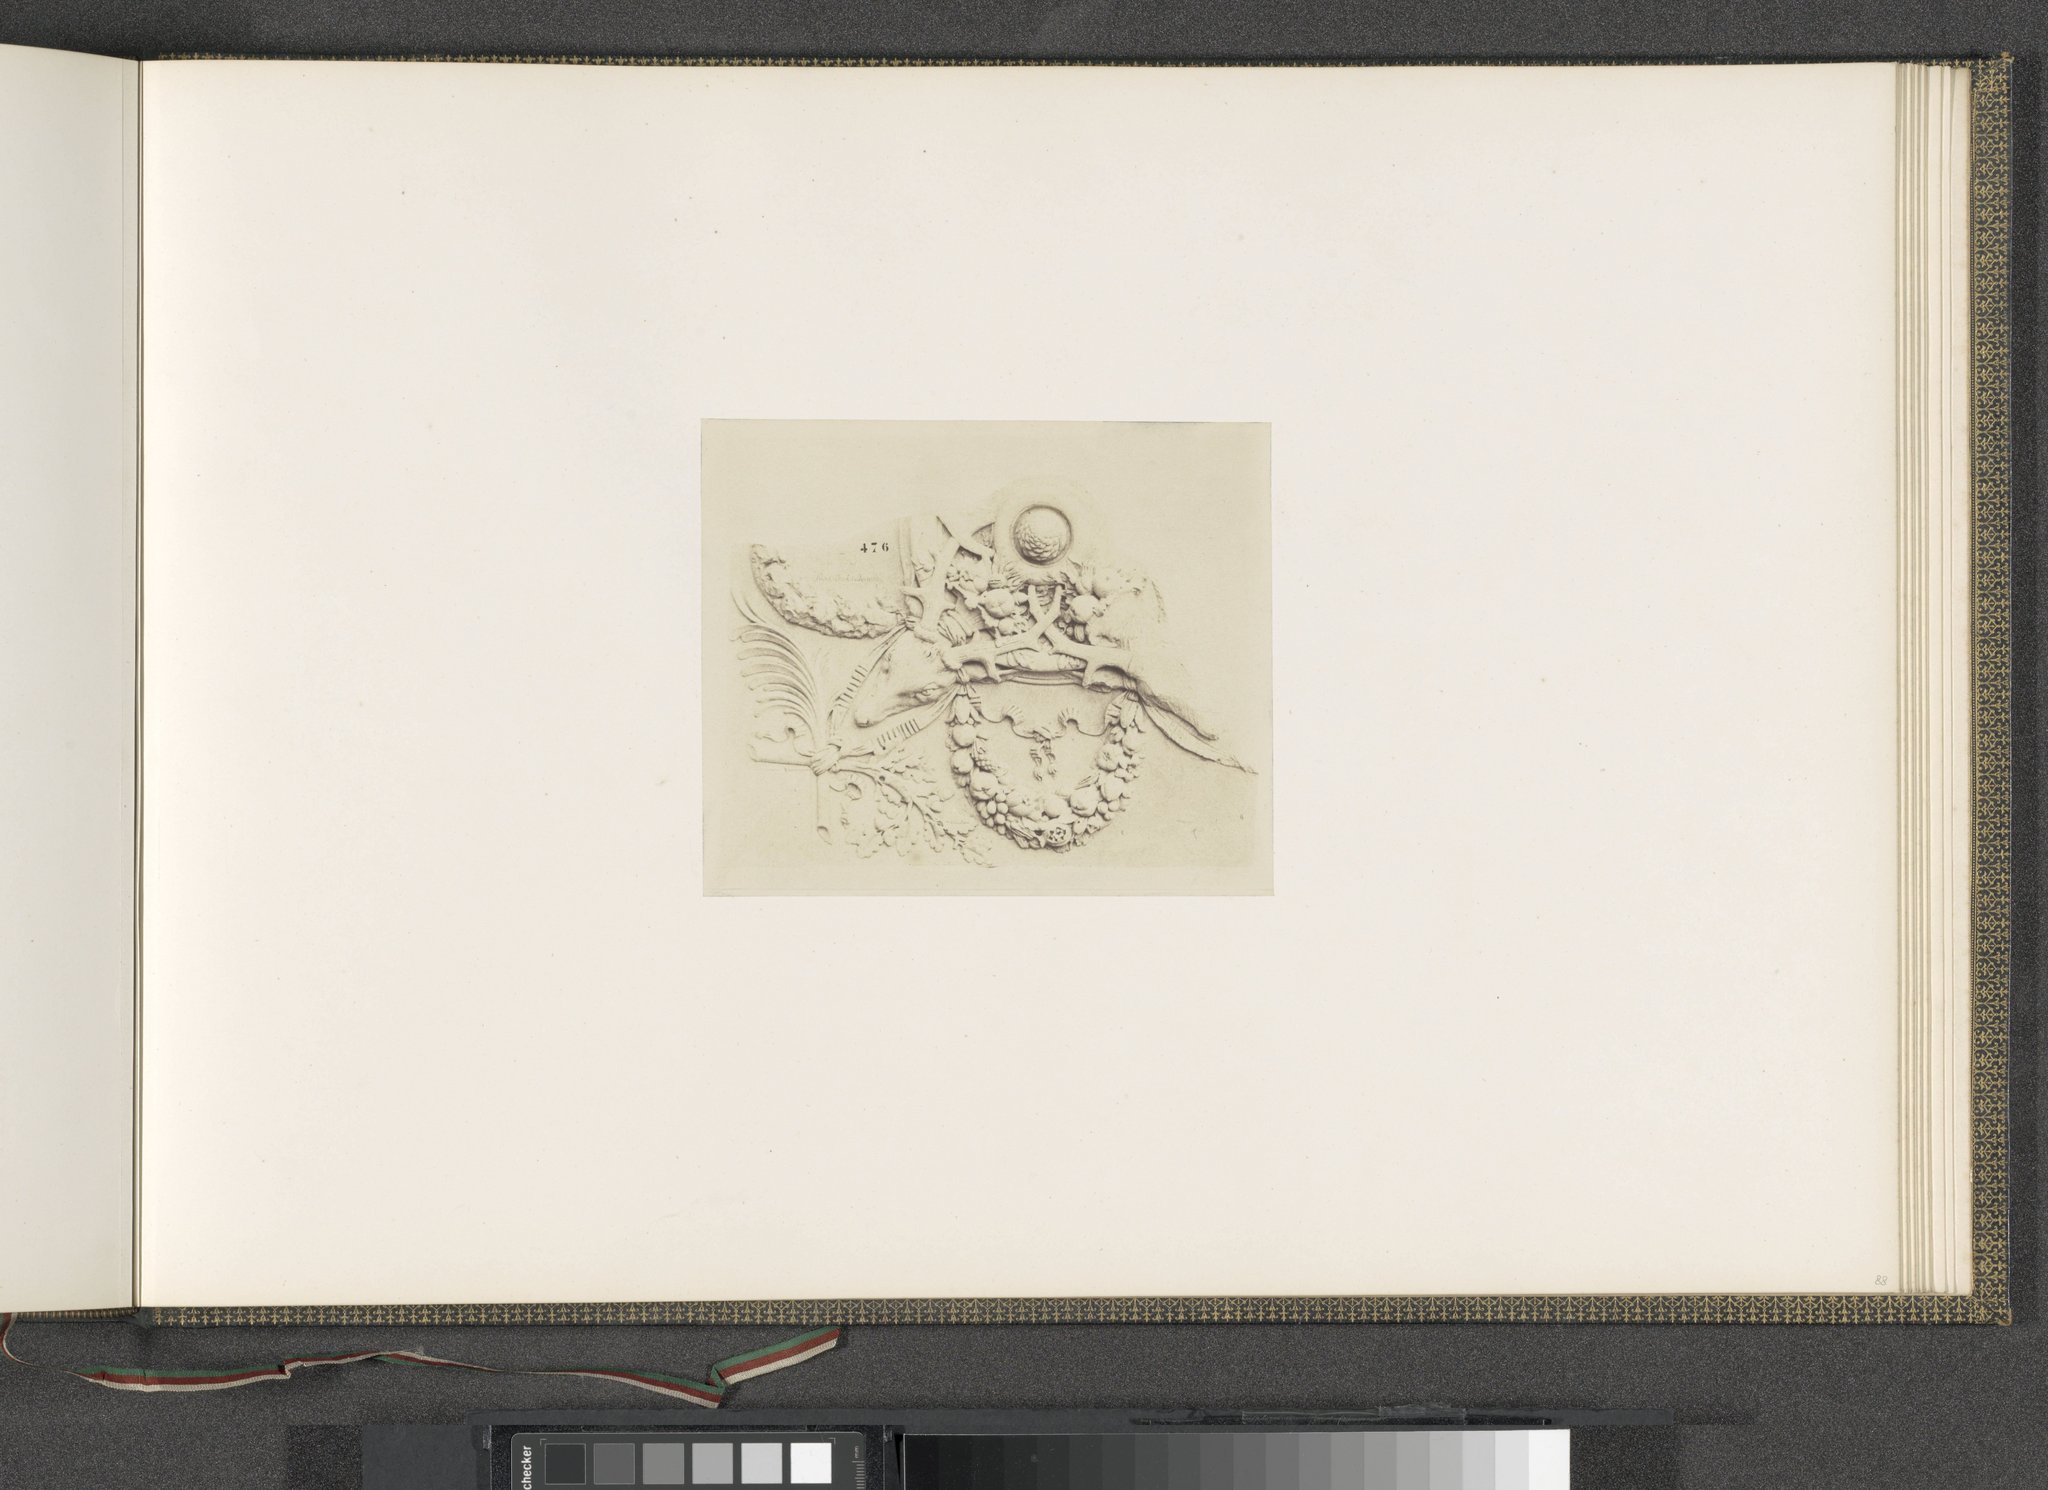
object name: photograph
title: Gipsmodel voor een versiering van het Palais du Louvre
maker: édouard denis baldus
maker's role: fotograaf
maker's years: 1813-1889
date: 1855-1857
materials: paper, photographic support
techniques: salted paper print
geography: paris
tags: permanent exhibition, museum, ornamenting, decorating ~ applied arts, paris, tuileries palace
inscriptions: number: ‘476’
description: Onderdeel van Réunion des Tuileries au Louvre 1852-1857, album 4.